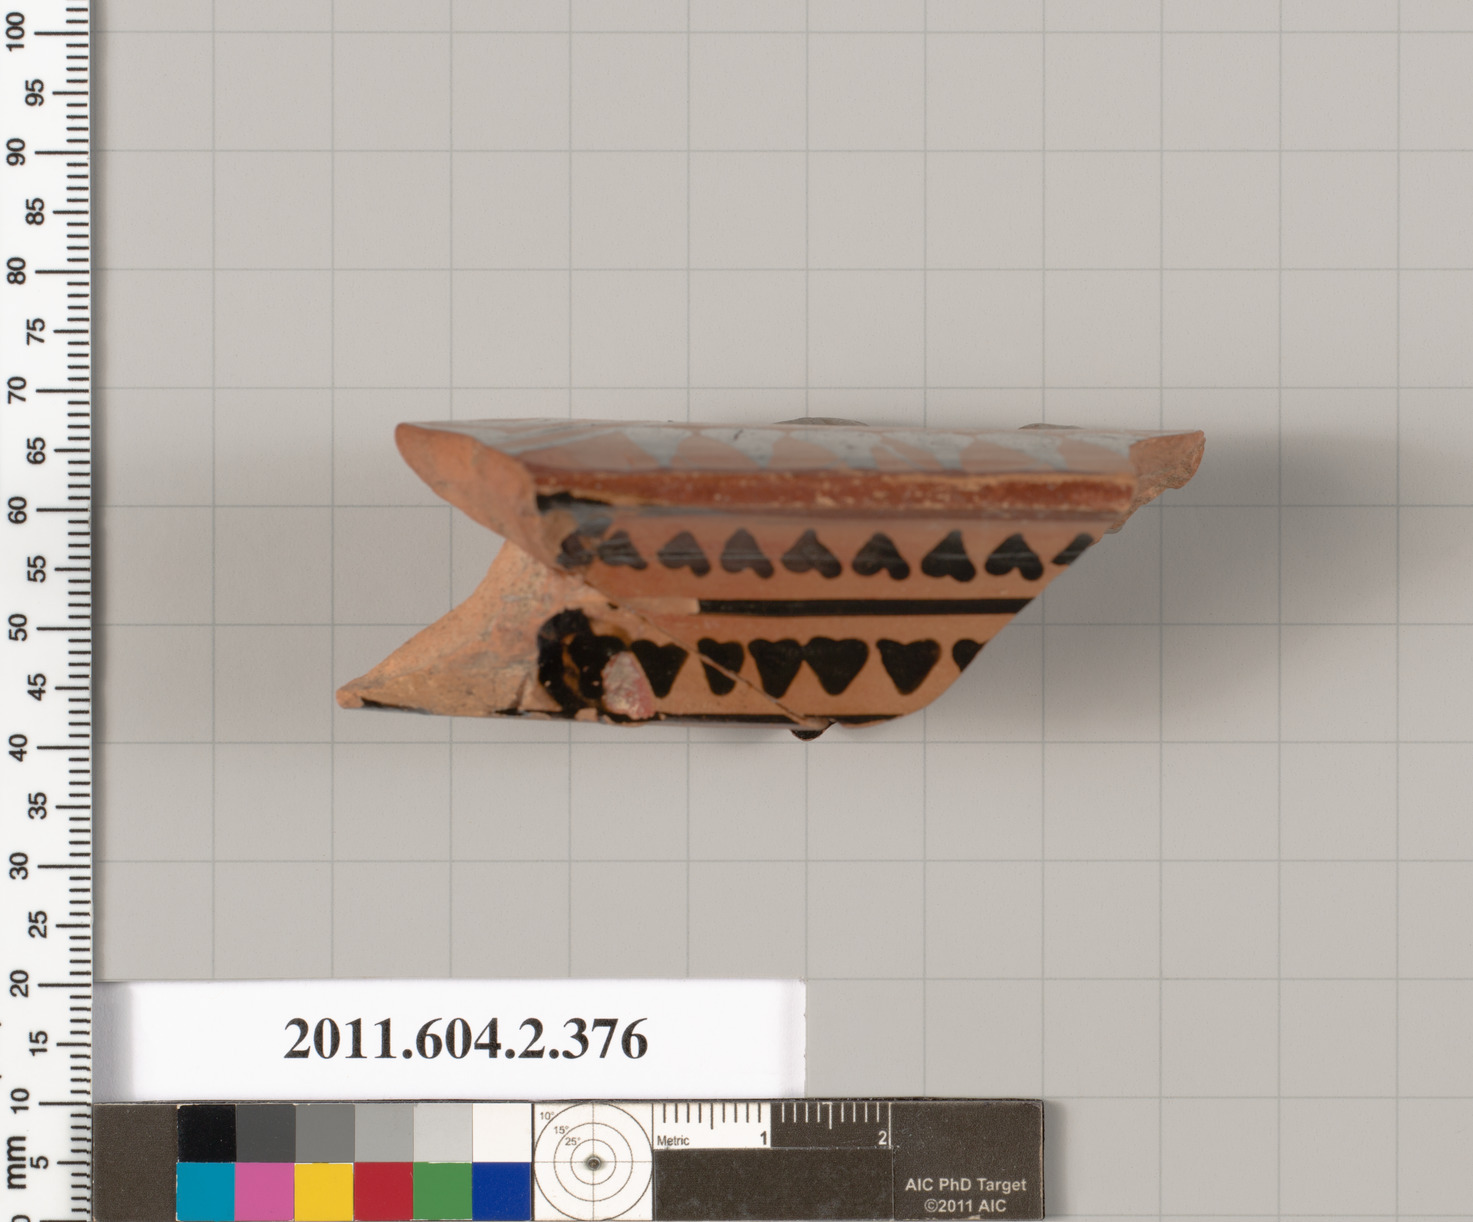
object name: column krater fragment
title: Terracotta fragment of a column-krater (bowl for mixing wine and water)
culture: greek, attic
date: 460-440 BCE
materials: terracotta